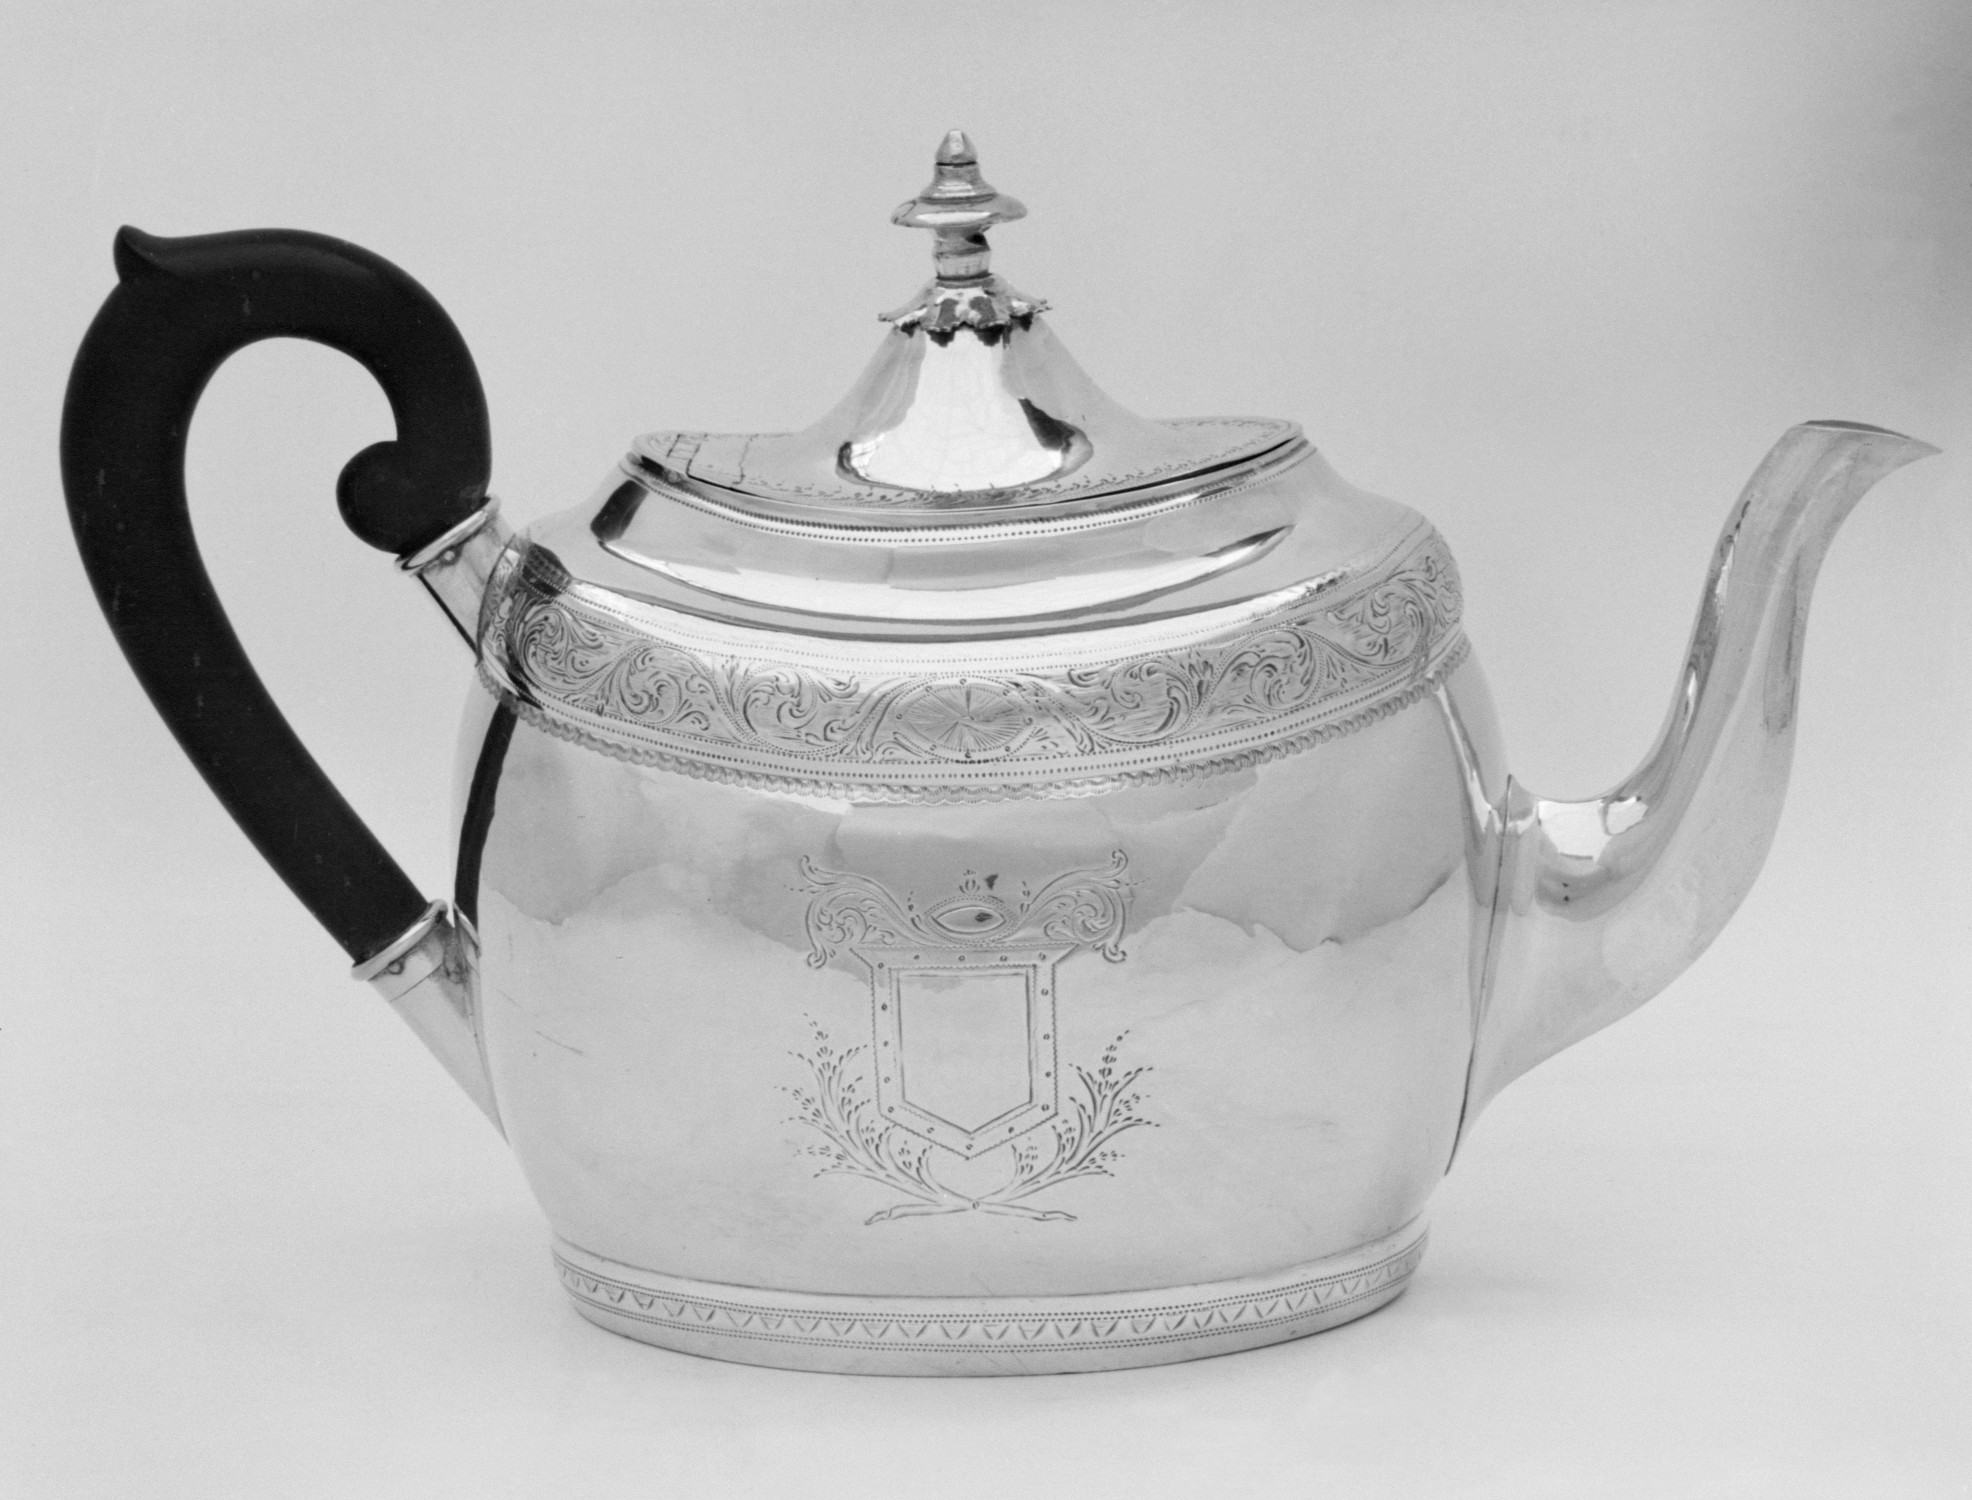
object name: teapot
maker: richard sawyer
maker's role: maker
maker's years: 1750-1850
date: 1801-1802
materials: silver, wood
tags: coat of arms